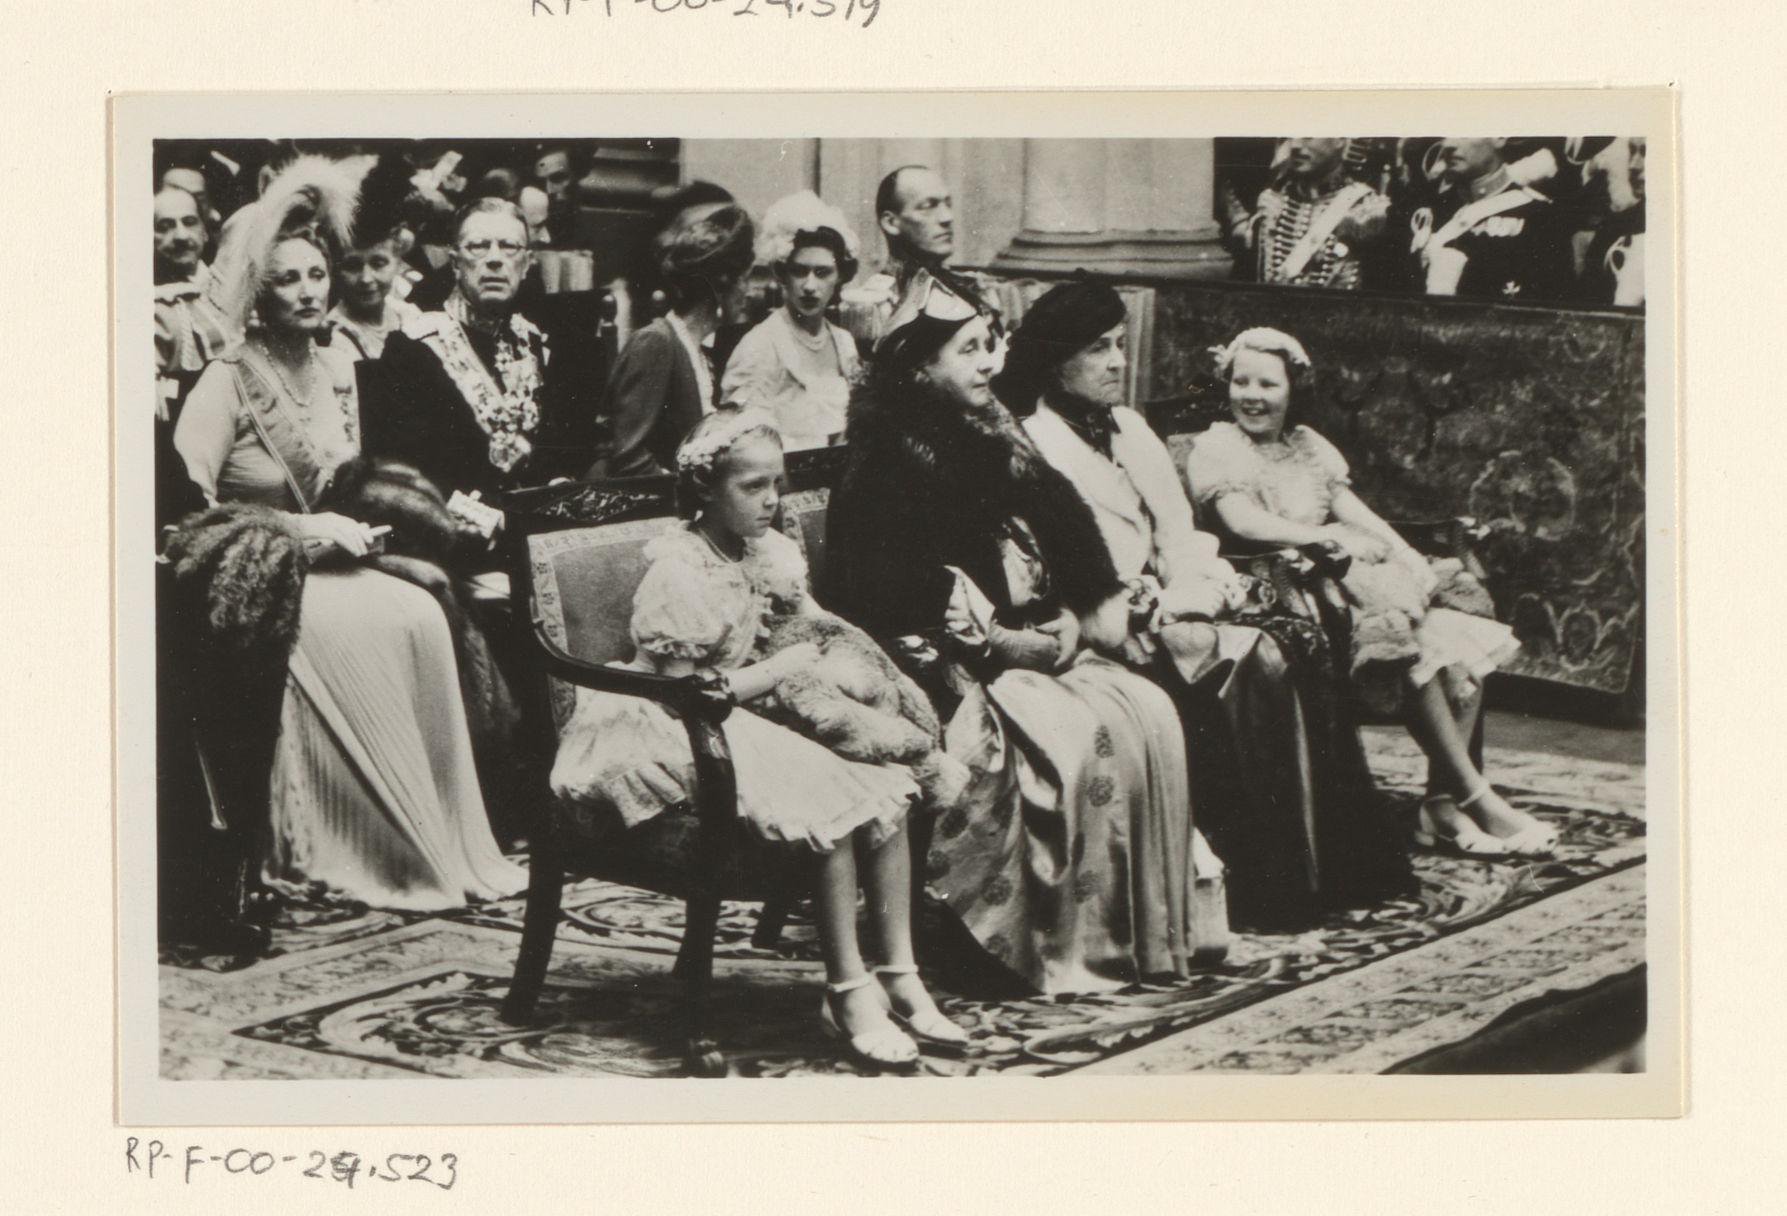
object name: ansichtkaart, prentbriefkaart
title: H.K.H. Prinses Wilhelmina, H.K.H. Prinses Armgard en de Prinsesjes Beatrix en Irene bij de inhuldiging in de Nieuwe Kerk te Amsterdam / 6 September 1948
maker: Anonymous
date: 1948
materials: paper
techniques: gelatin silver print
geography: amsterdam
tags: the hague, print maker, wilhelmina of the netherlands, beatrix (koningin der nederlanden), historical persons - bb - woman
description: Prinses Wilhelmina en Prinses Armgard met de prinsesjes Beatrix en Irene. Tijdens de inhuldiging in de Nieuwe Kerk te Amsterdam op 6 september 1948.